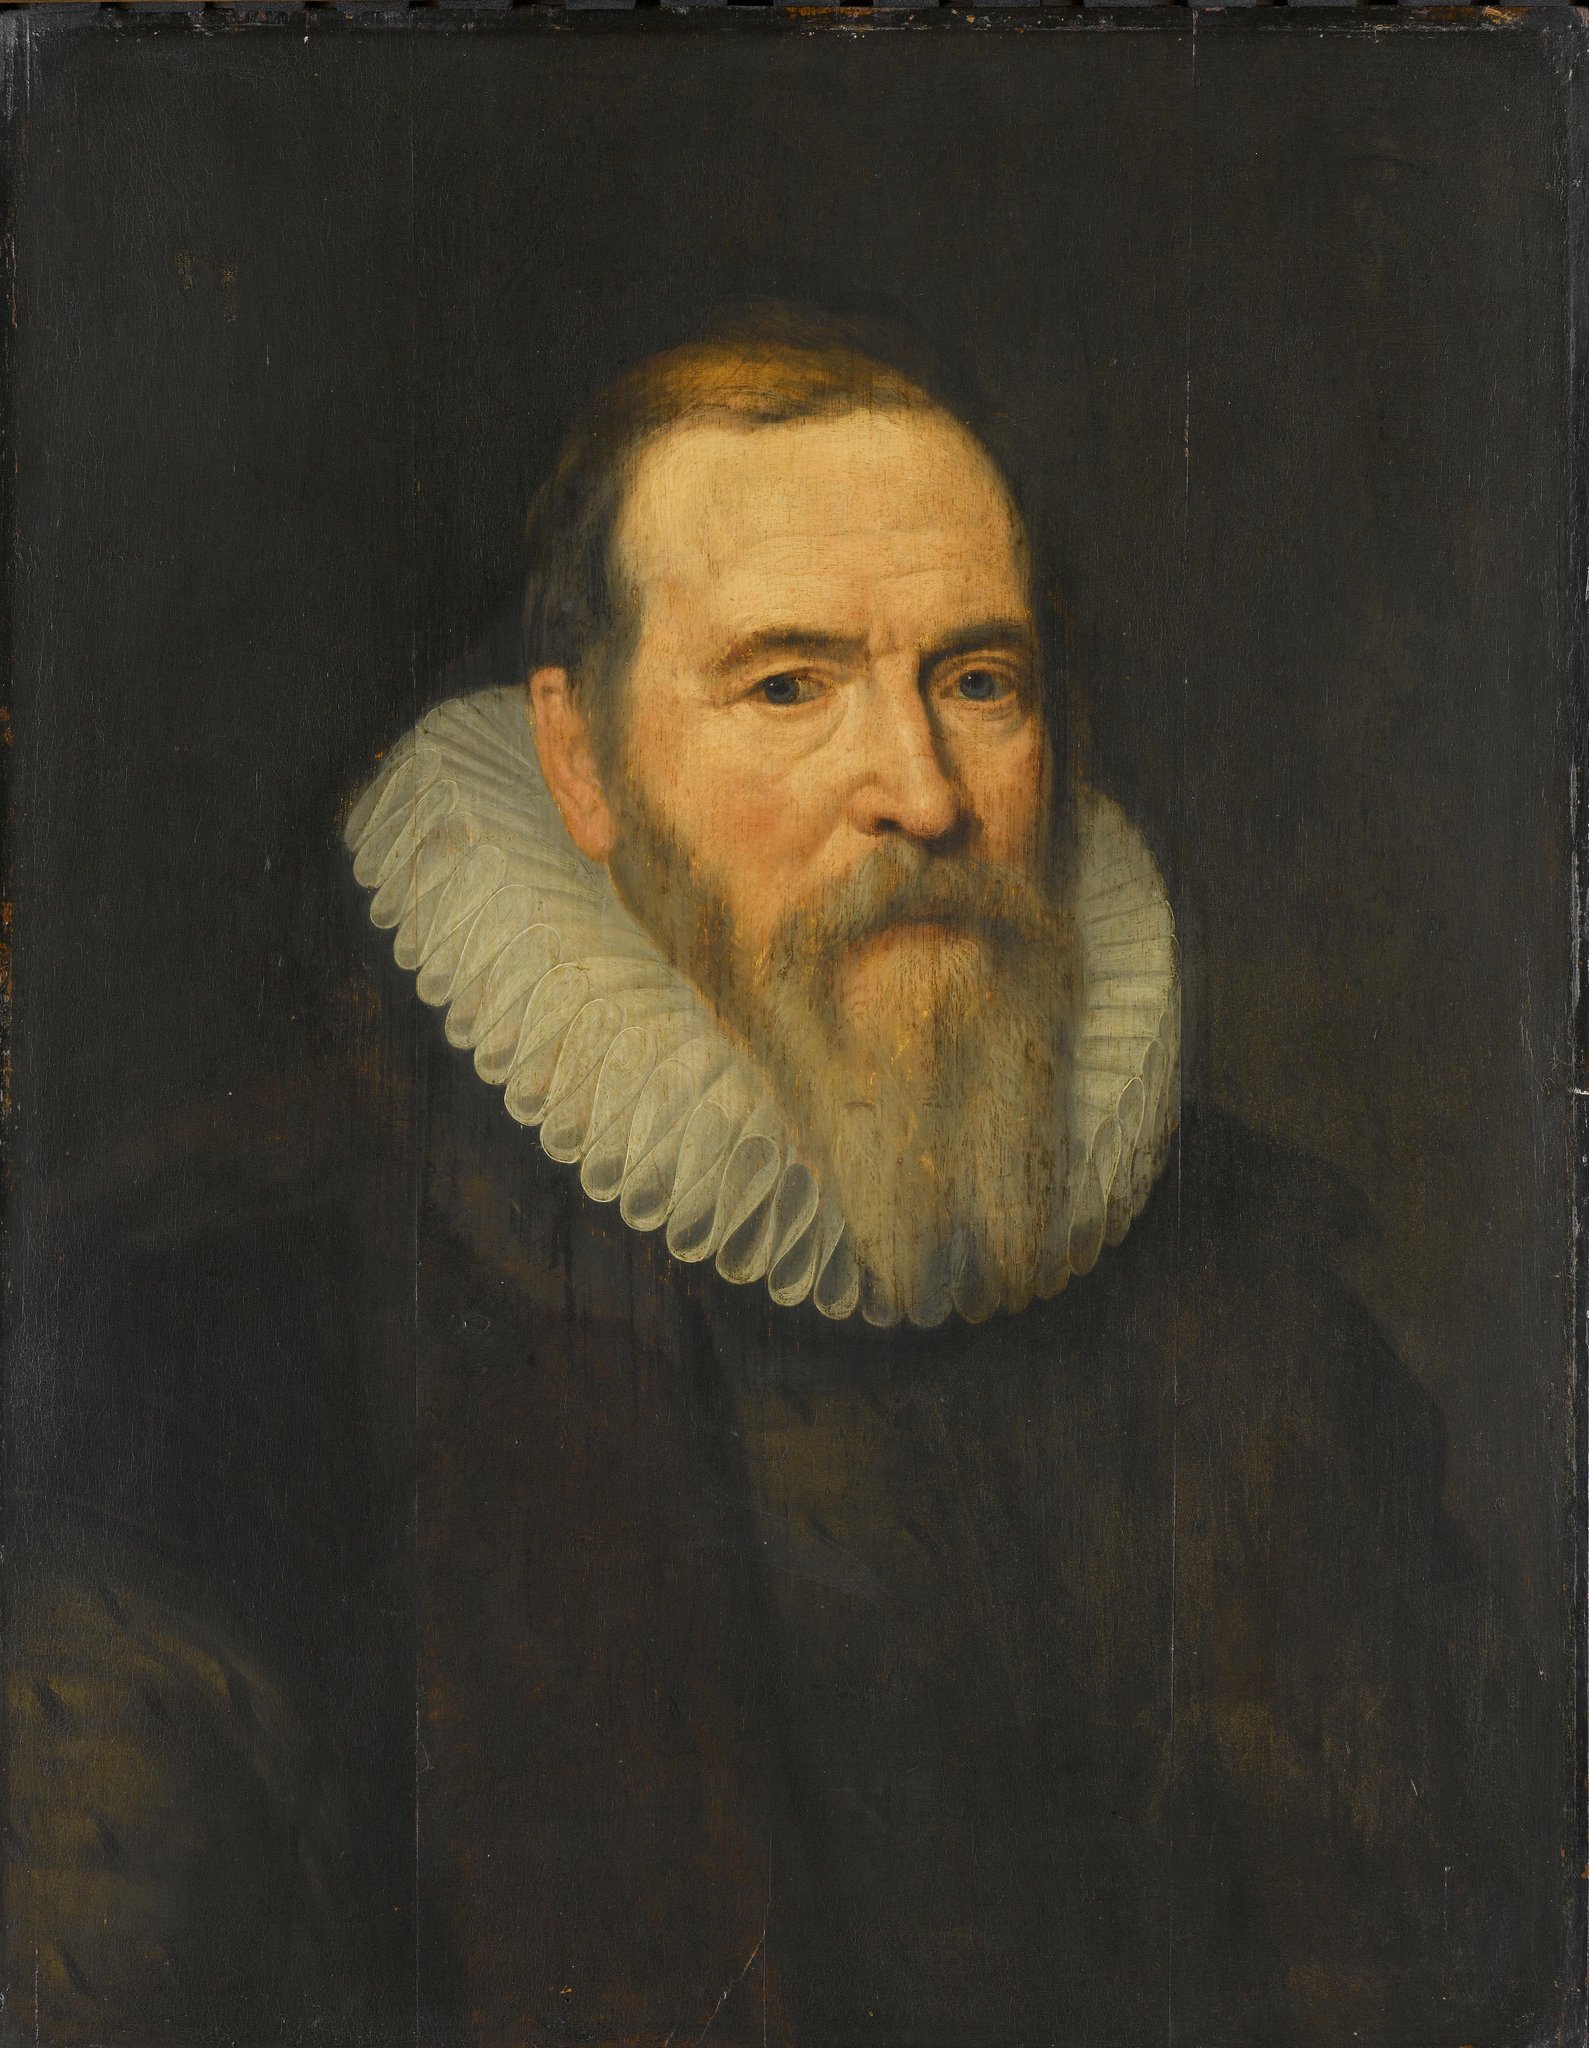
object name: painting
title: Portrait of Johan van Oldenbarnevelt (1547-1619)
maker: michiel jansz van mierevelt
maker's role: draughtsman, painter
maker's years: 1567-1641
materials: oil, panel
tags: johan van oldenbarnevelt, historical persons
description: In this portrait Johan van Oldenbarnevelt is 67 years old. For close to thirty years he has held the highest governmental position in Holland and been the most powerful politician in the Republic. For a long time he is someone to contend with. Maurice is greatly indebted to him, yet after 1610 a conflict arises between them that gravely disrupts the country. Which of them will determine the future?